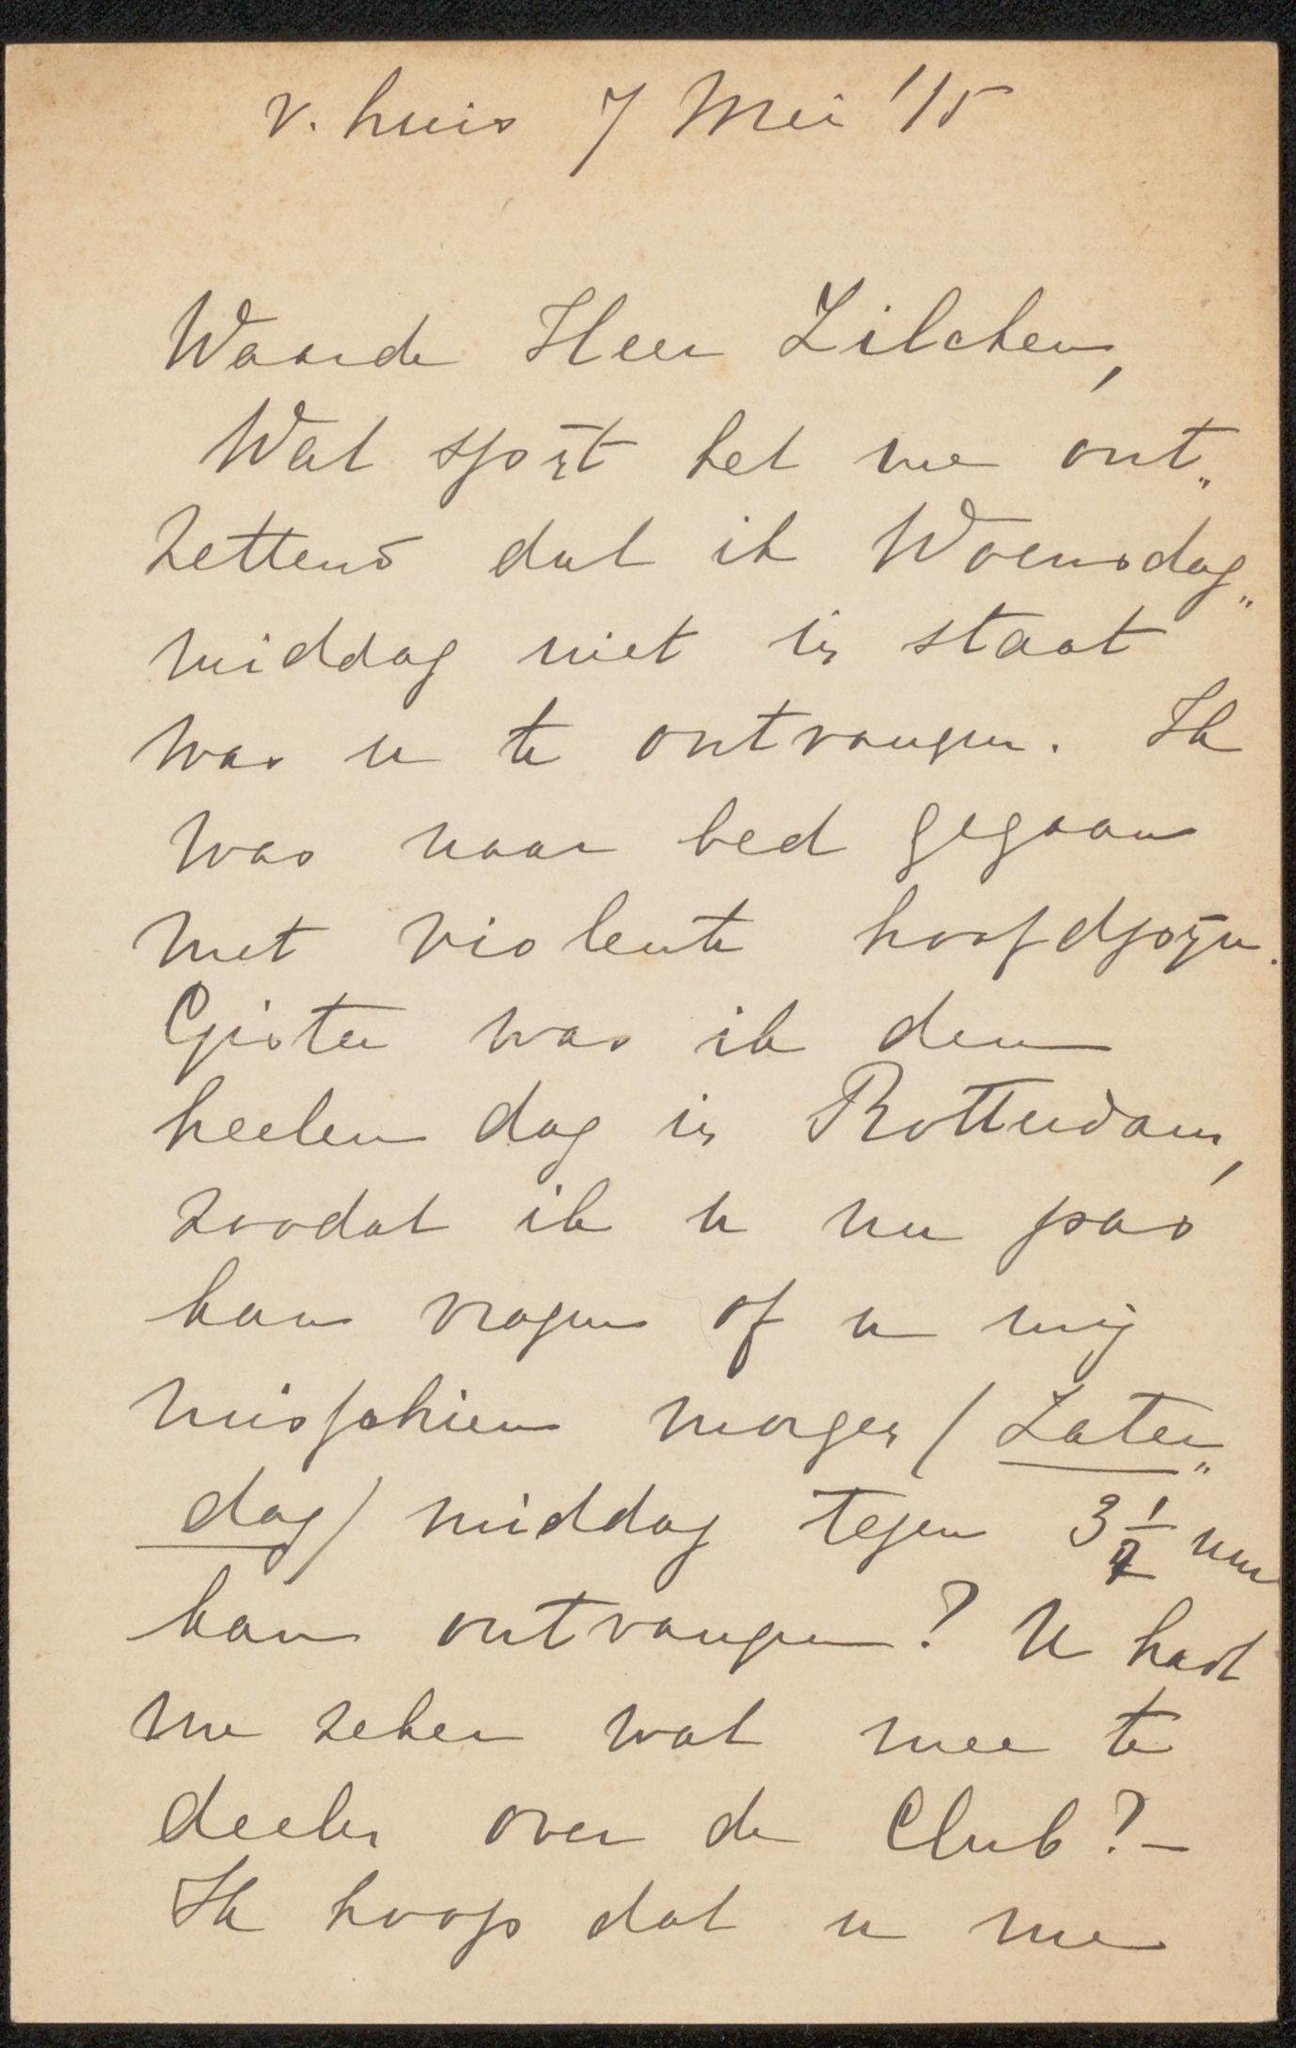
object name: letter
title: Brief aan Philip Zilcken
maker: fenna de meyier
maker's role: onderwijzer, schrijver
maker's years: 1874-1943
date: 1915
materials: ink, paper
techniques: pen, writing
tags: the hague, painter, draughtsman, philip zilcken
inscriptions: collector's mark: ‘RPK’